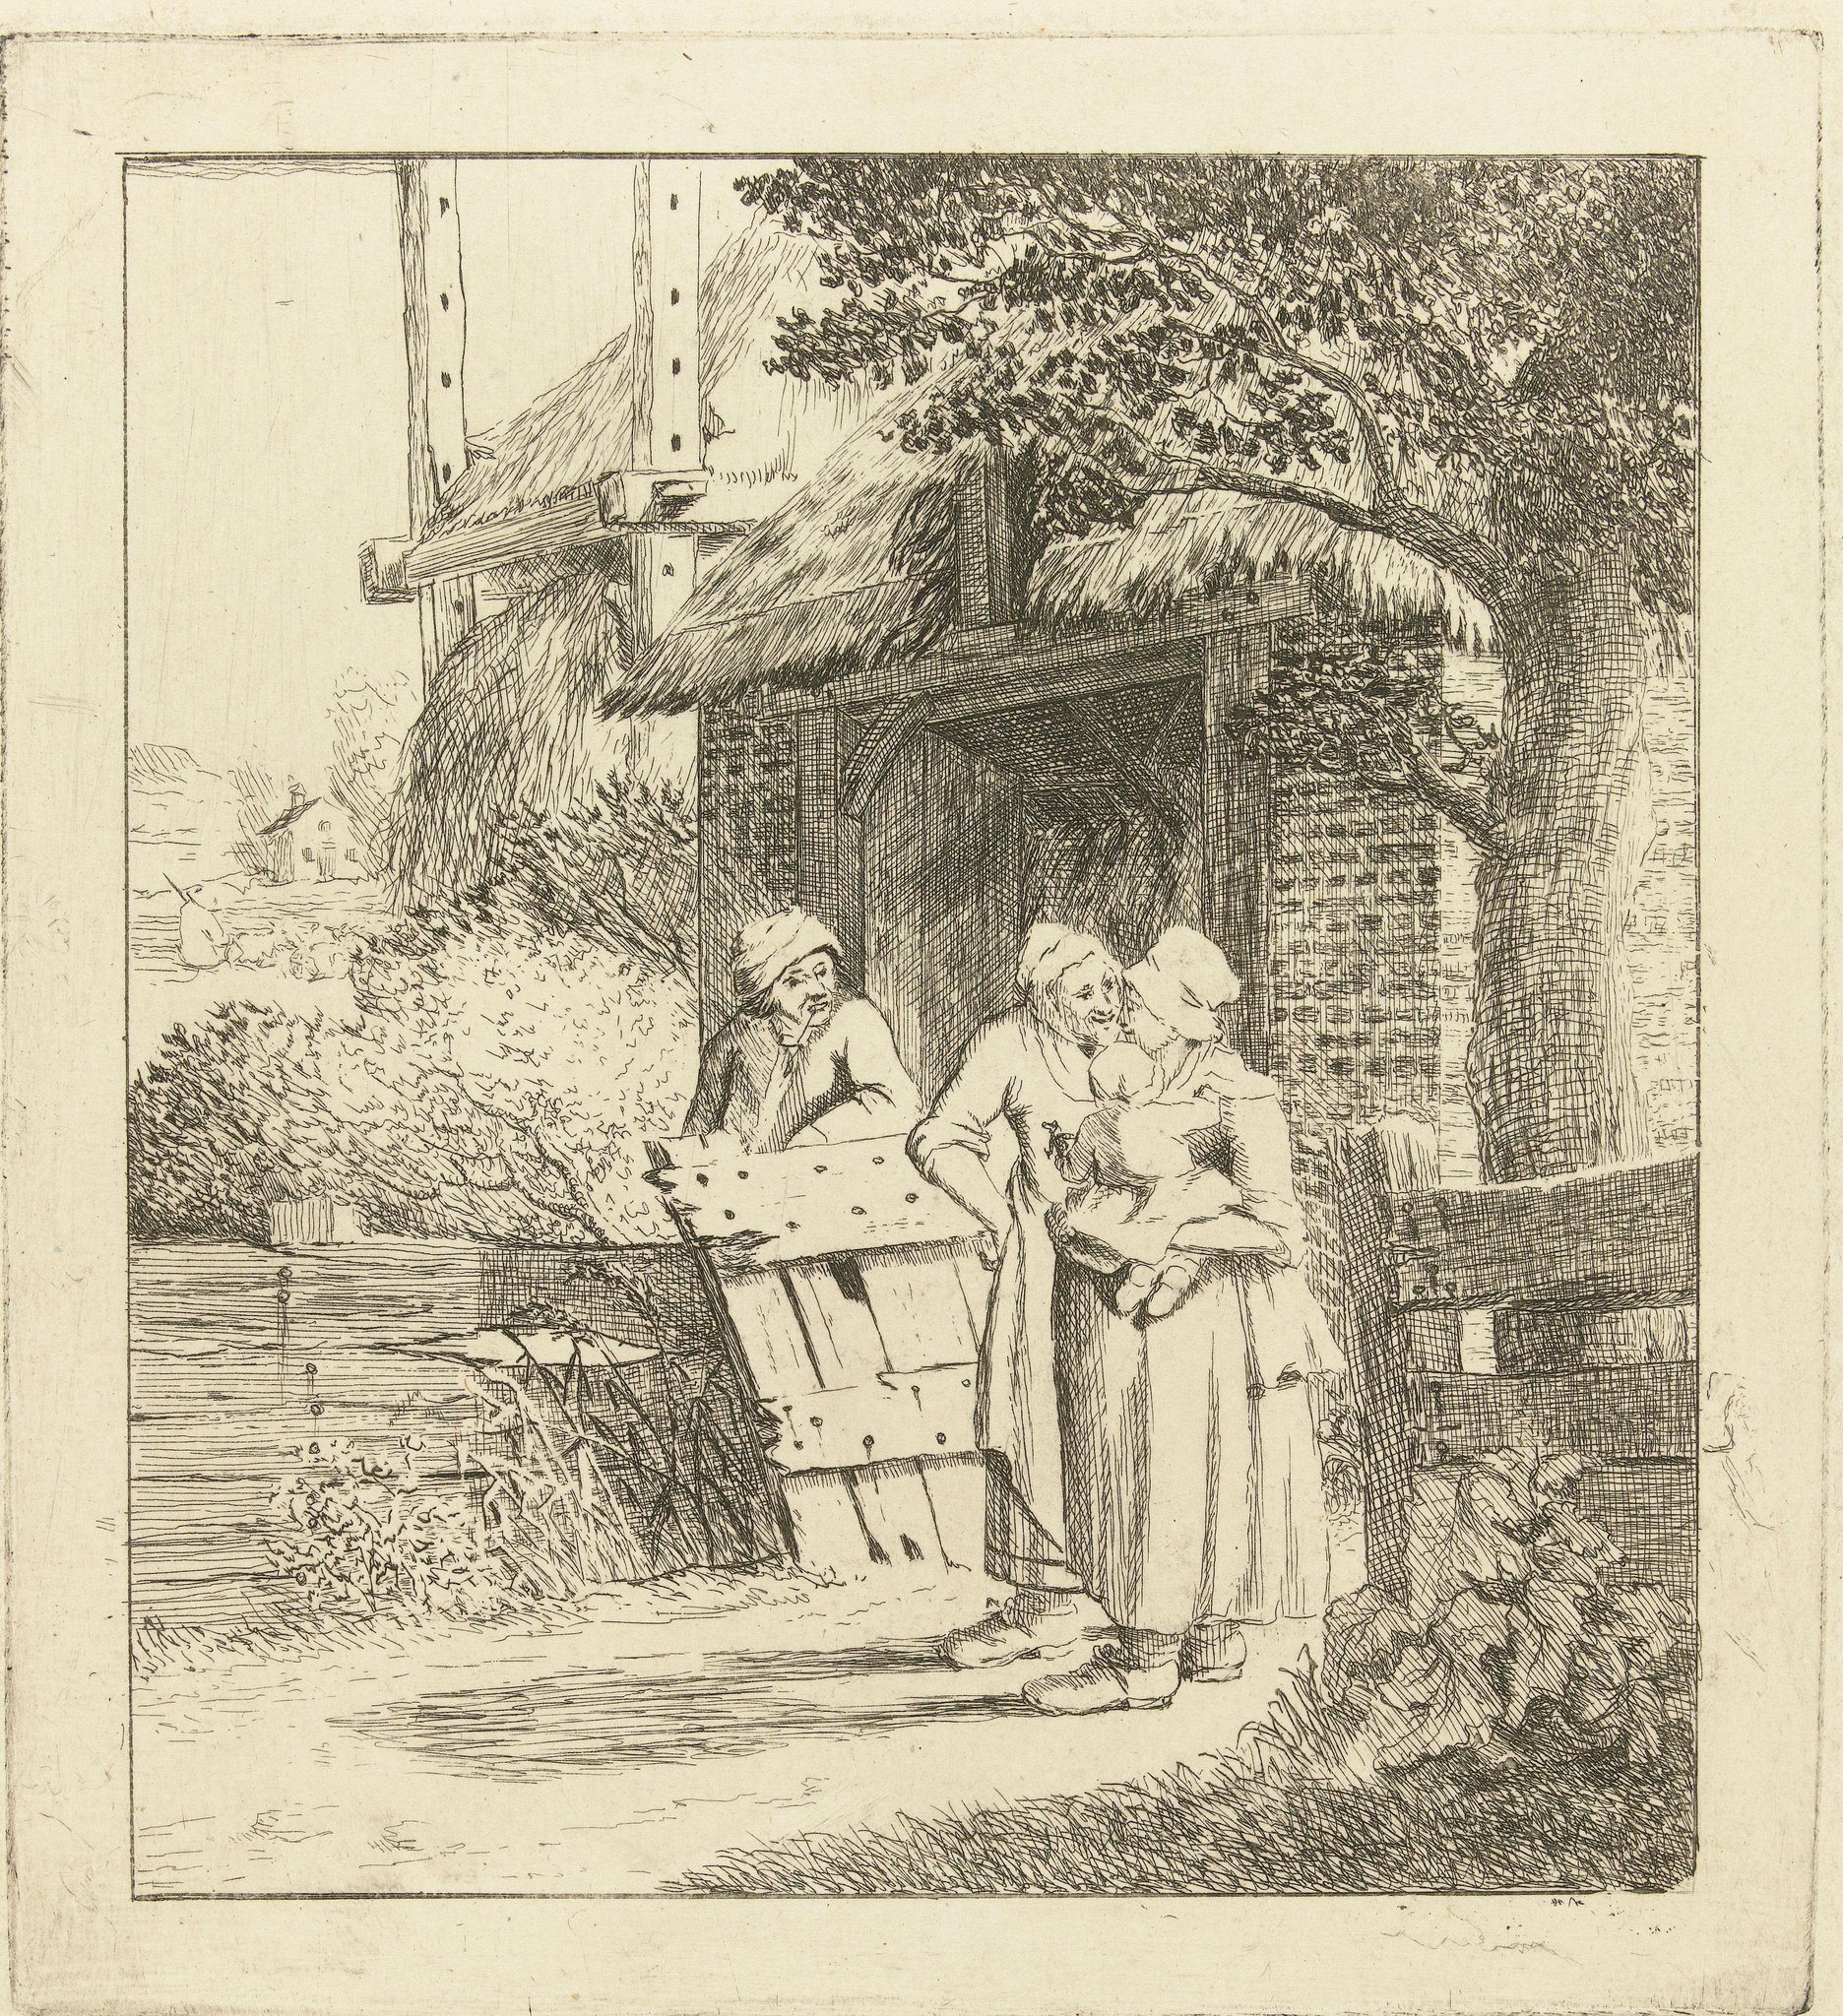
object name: print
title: Twee vrouwen en een man voor een boerderij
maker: marie lambertine coclers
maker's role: conservator, draughtsman, print maker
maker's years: 1761-1815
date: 1776-1815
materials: paper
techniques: drypoint, etching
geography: amsterdam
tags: hay-stack, conversation, dialogue; conversation piece, farm (building)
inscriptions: collector's mark: Lugt 2228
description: Bij het hek van een boerderij staan een oude vrouw en een jonge vrouw met een kind op haar arm te kletsen. Voor de deur van het huis staat een boer met een pijp. Achter de boerderij is een deel van een grote hooistapel te zien.